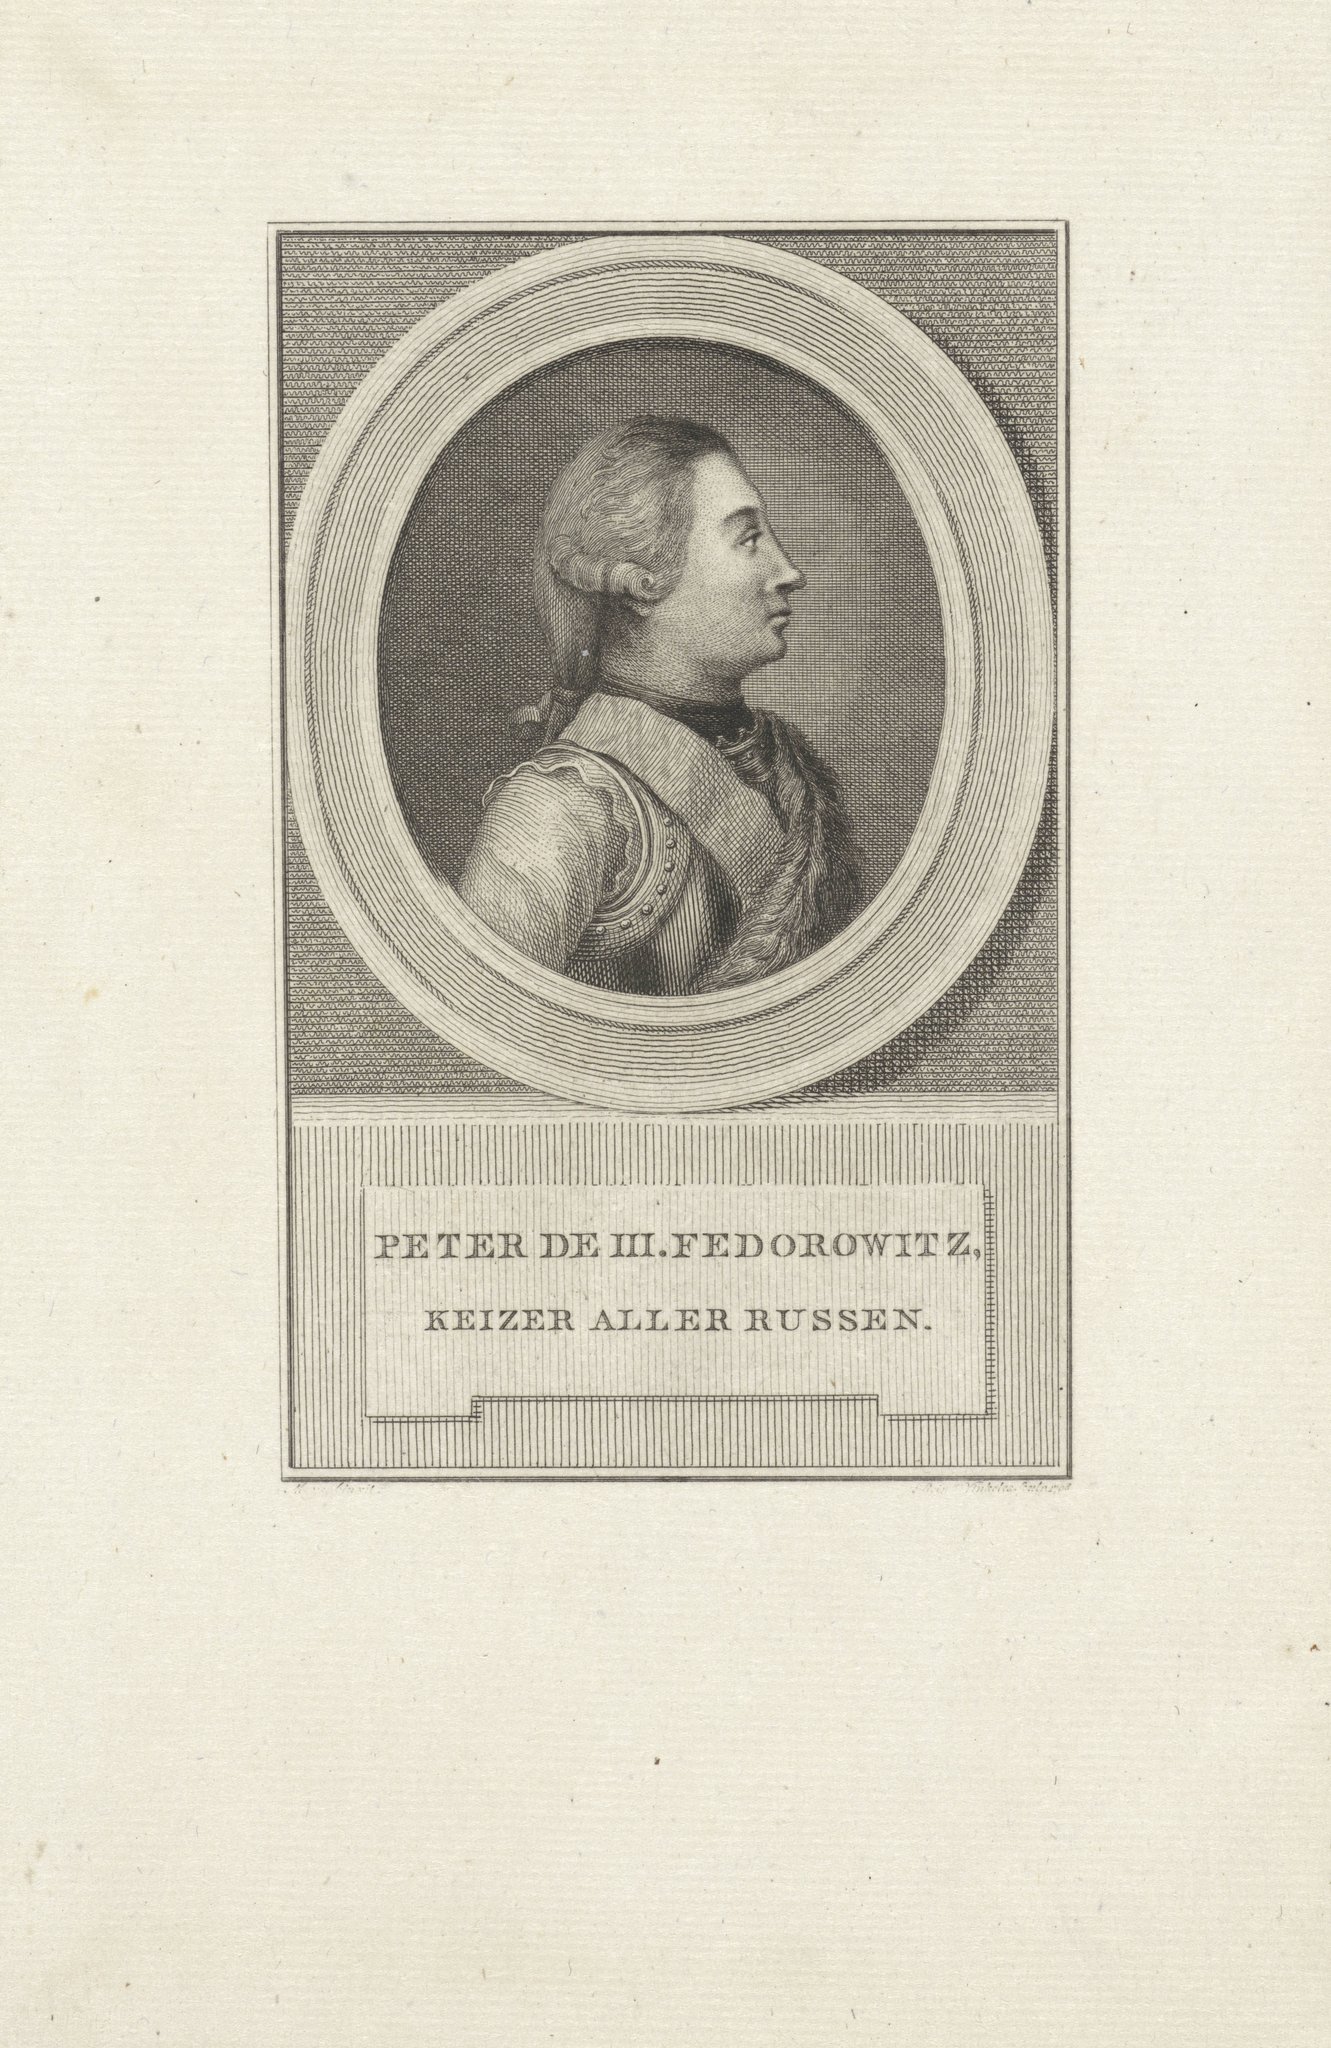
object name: print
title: Portret van tsaar Peter III van Rusland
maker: reinier vinkeles (i)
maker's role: draughtsman, print maker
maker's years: 1741-1816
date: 1762-1816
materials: paper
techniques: engraving, etching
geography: amsterdam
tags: peter iii van rusland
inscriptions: collector's mark: Lugt 240